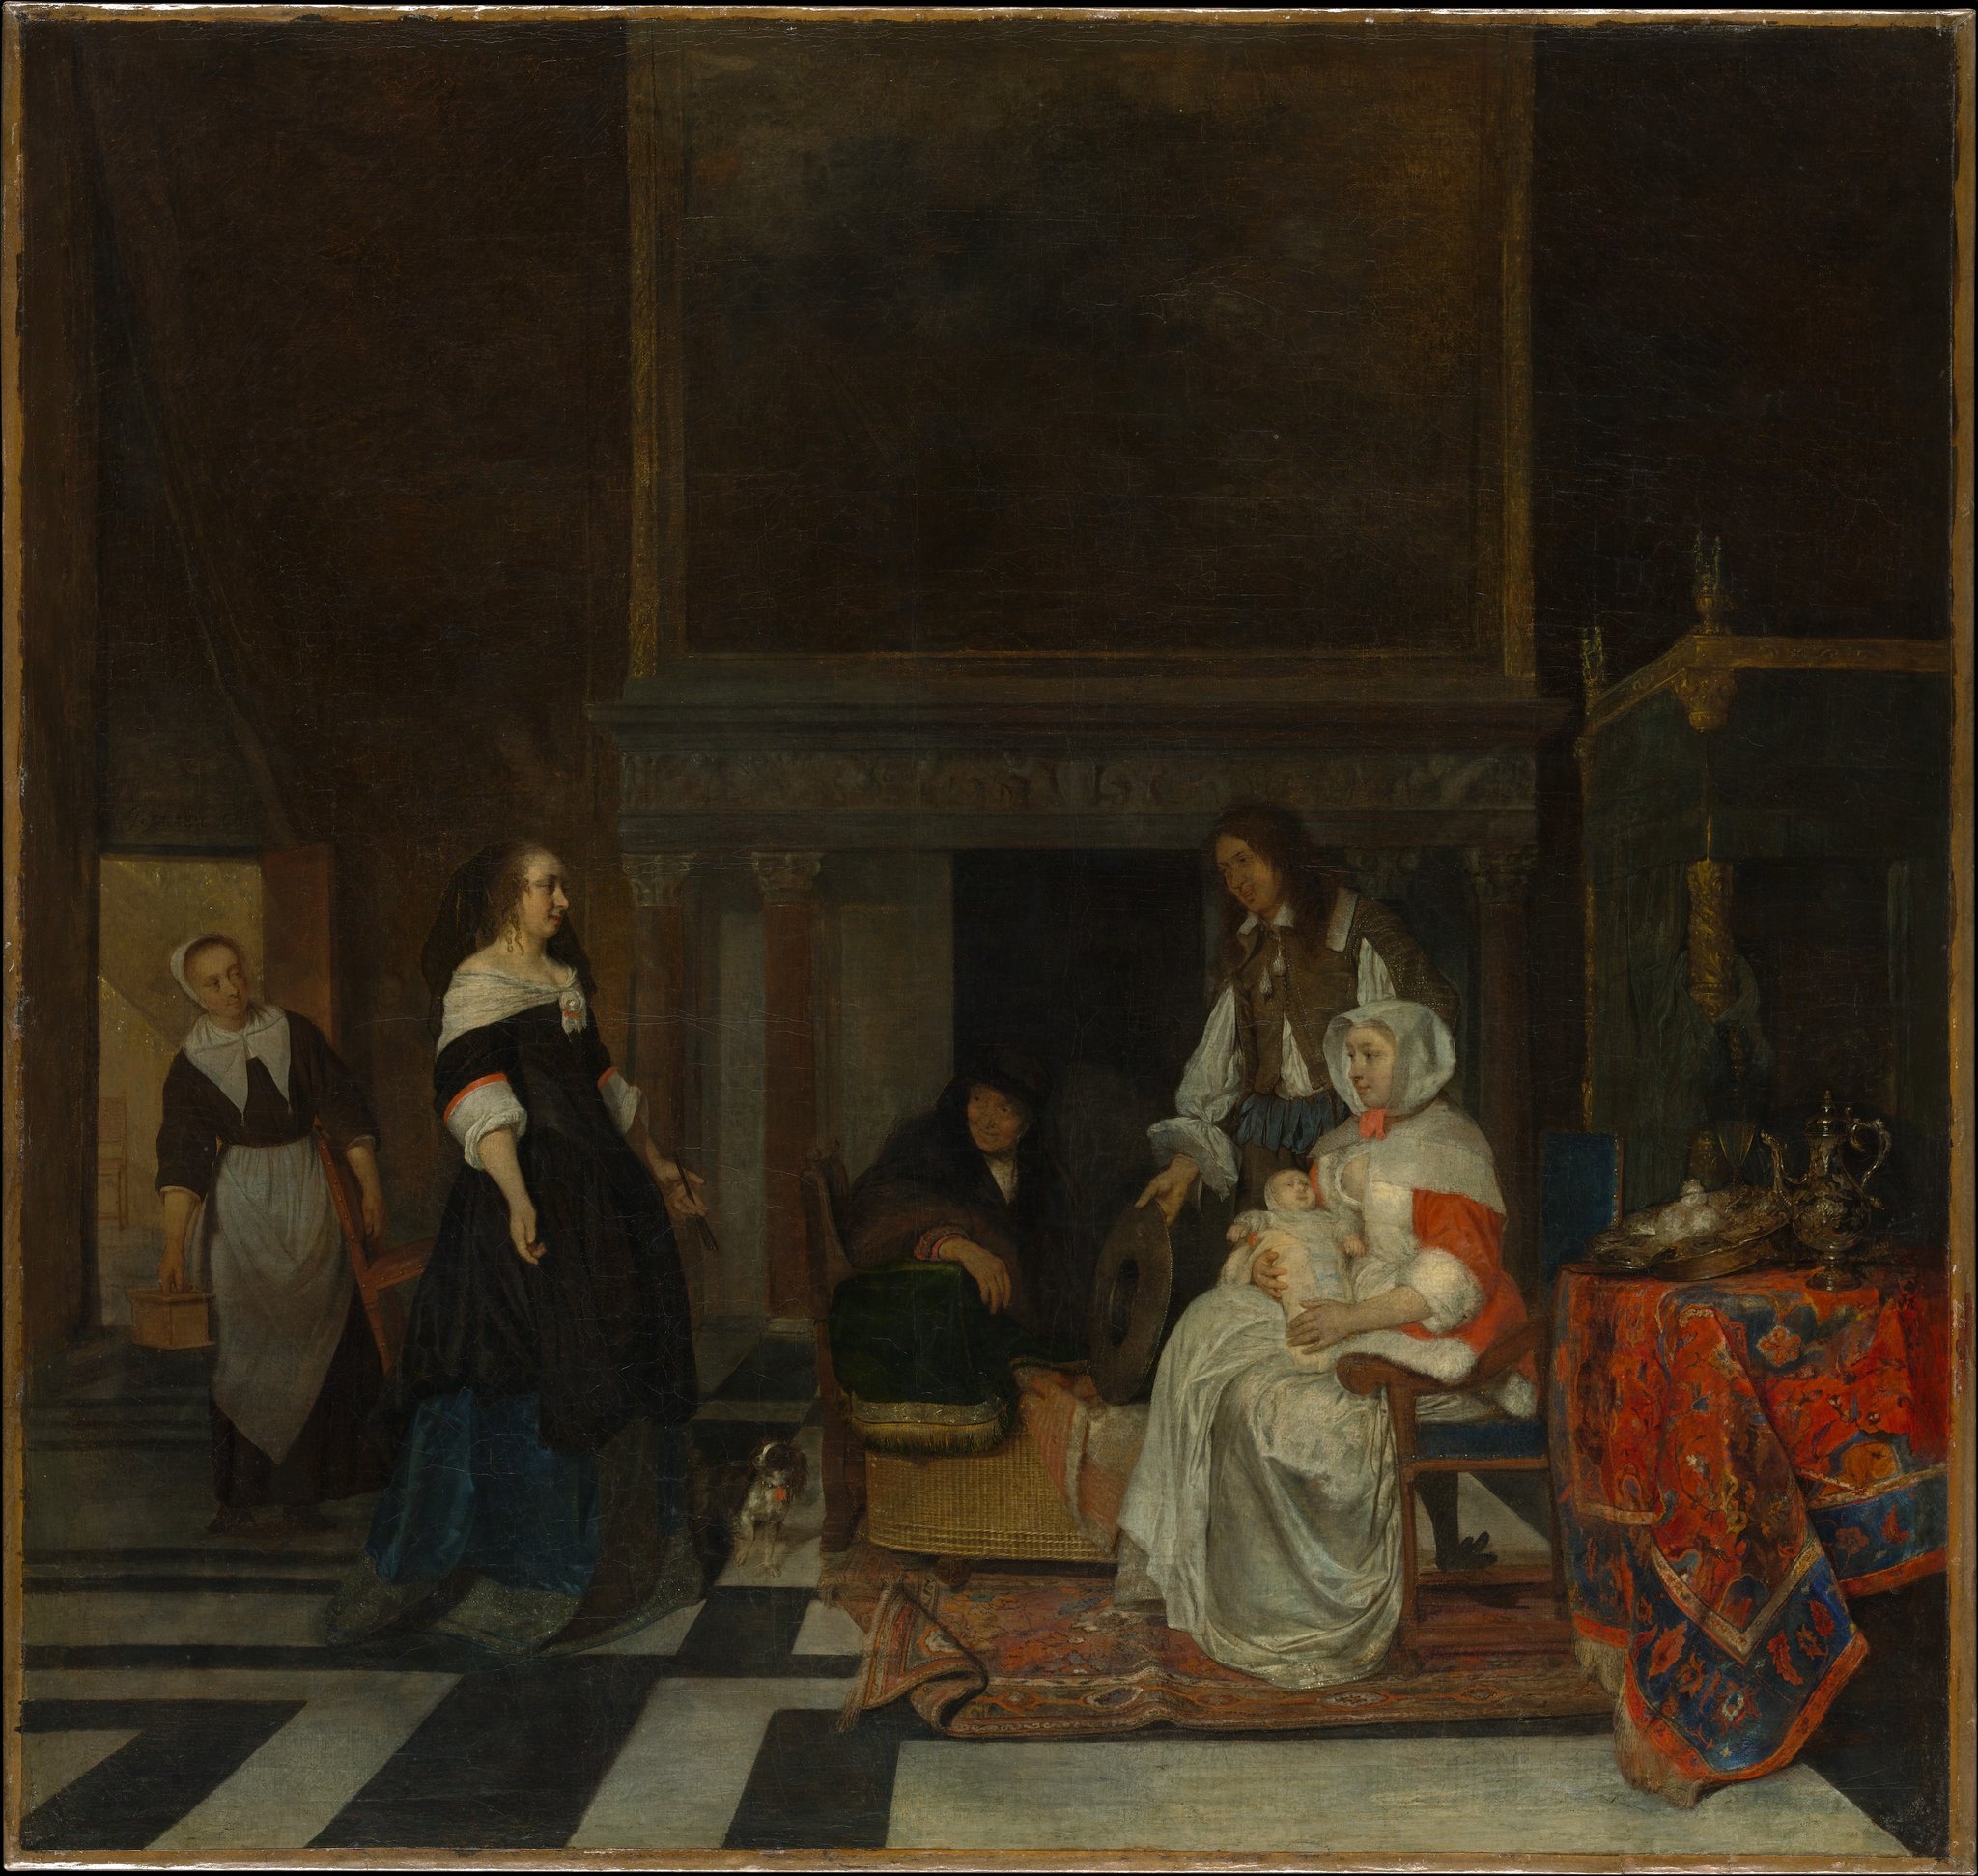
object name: painting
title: The Visit to the Nursery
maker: gabriël metsu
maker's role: artist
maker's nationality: dutch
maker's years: 1629-1667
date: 1661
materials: canvas, oil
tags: bedrooms,infants,men,women,dogs,servants